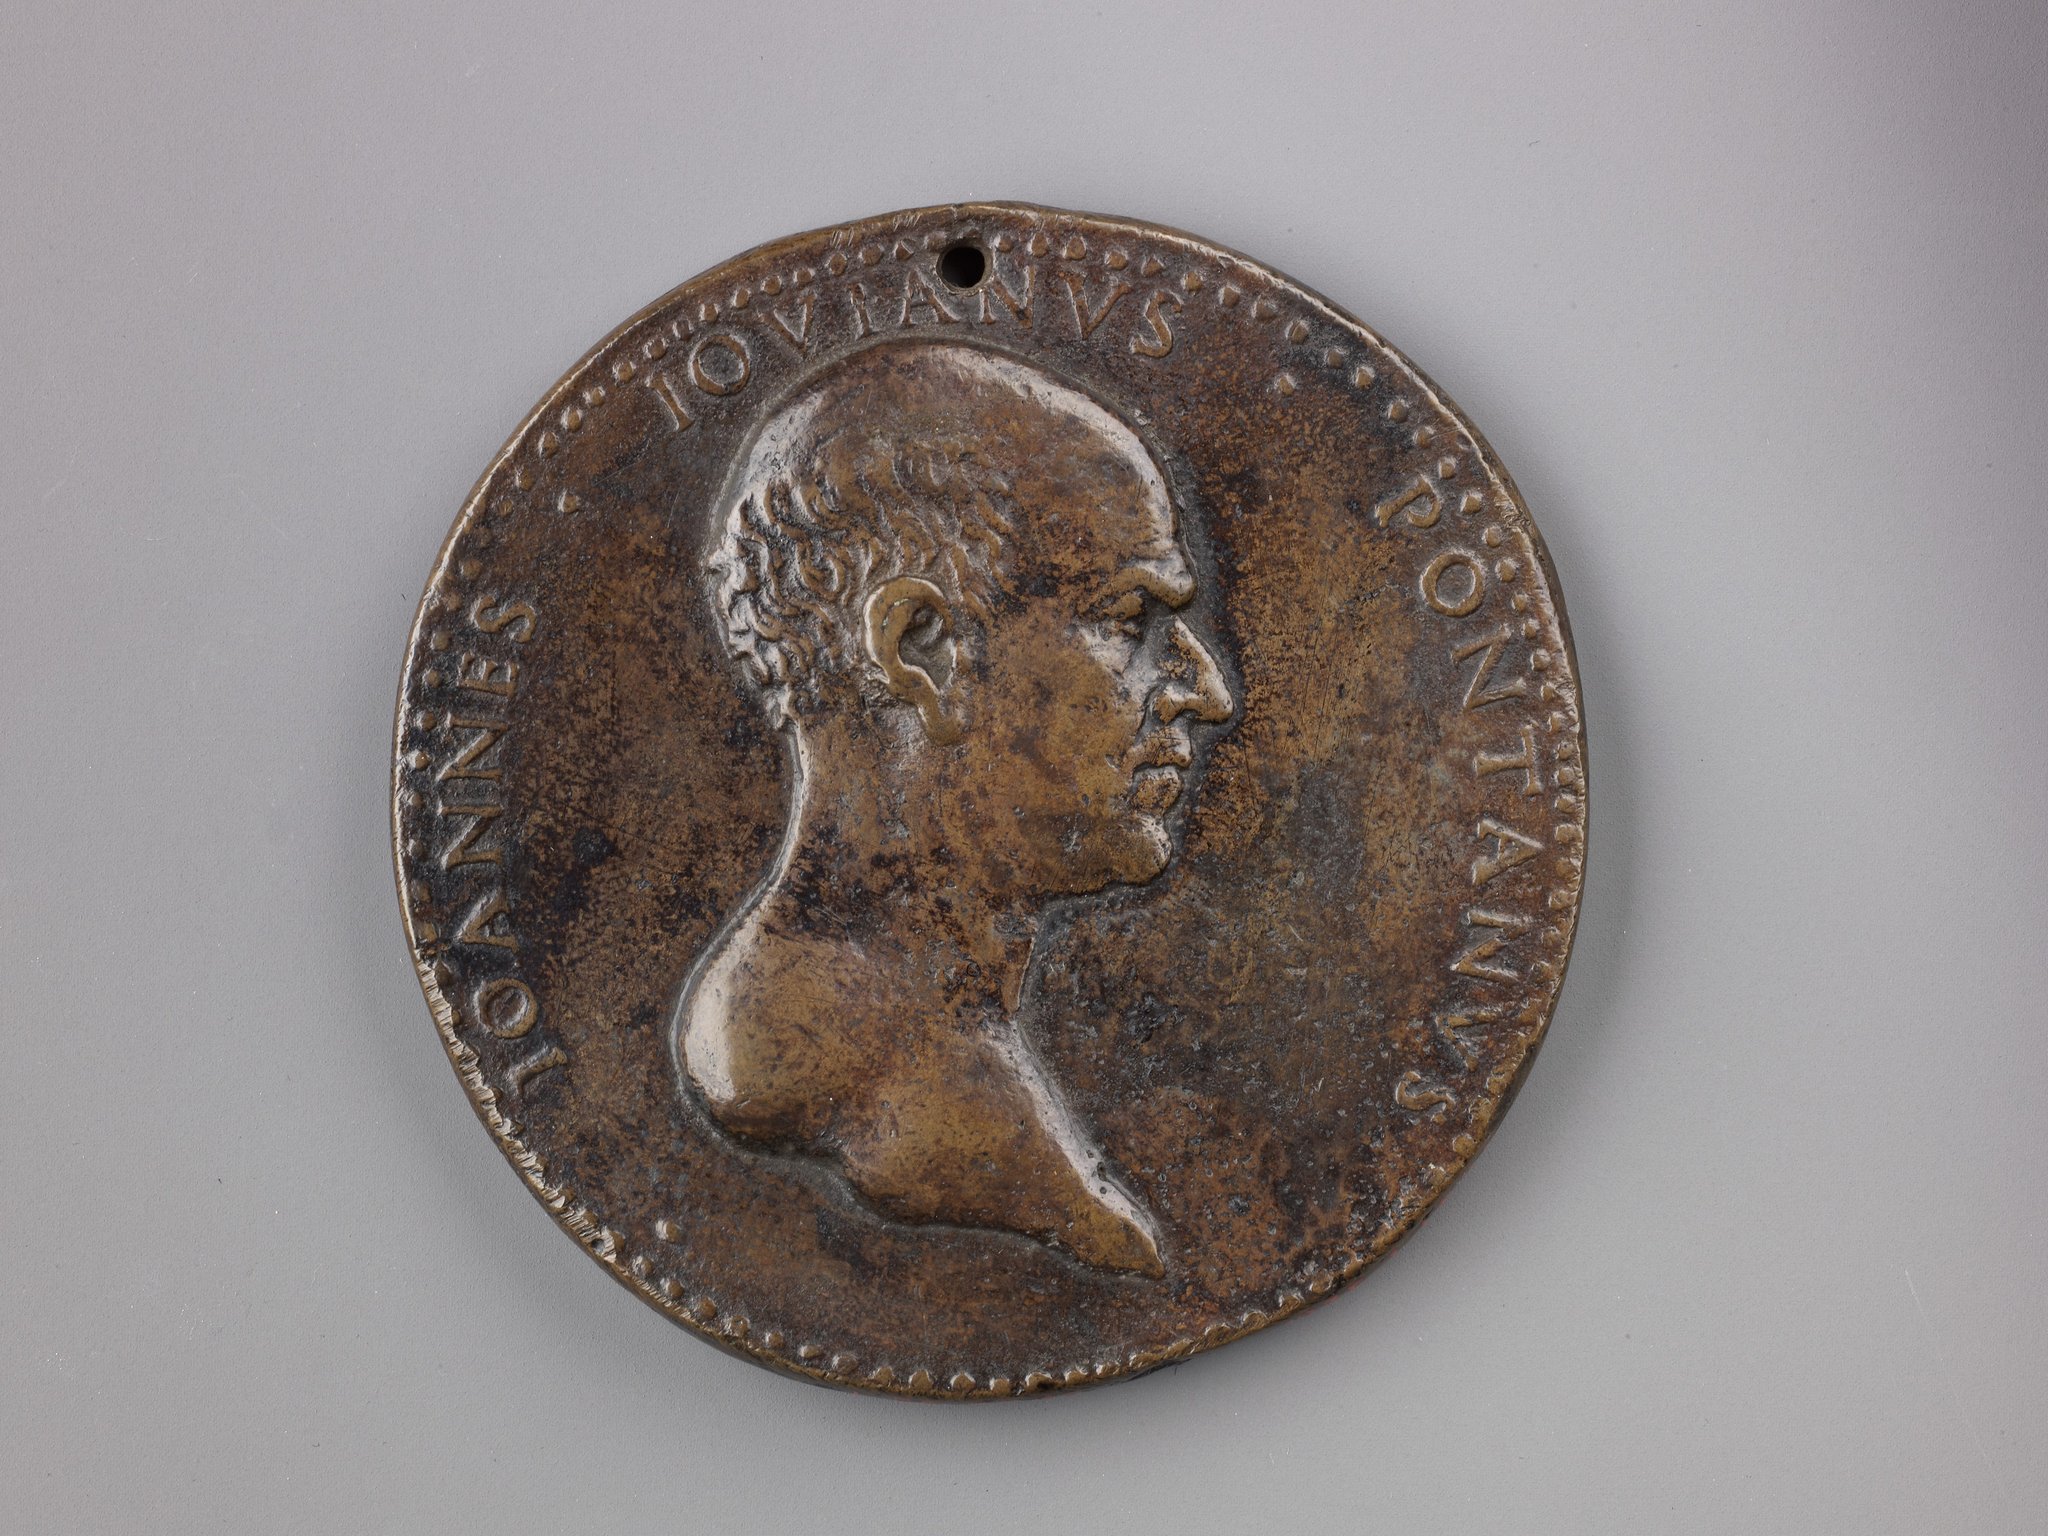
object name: medal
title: Portrait medal of Giovanni Giovano Pontano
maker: adriano fiorentino (adriano di giovanni de' maestri)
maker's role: artist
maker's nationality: italian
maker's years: 1450-1499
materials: bronze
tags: men,portraits,profiles